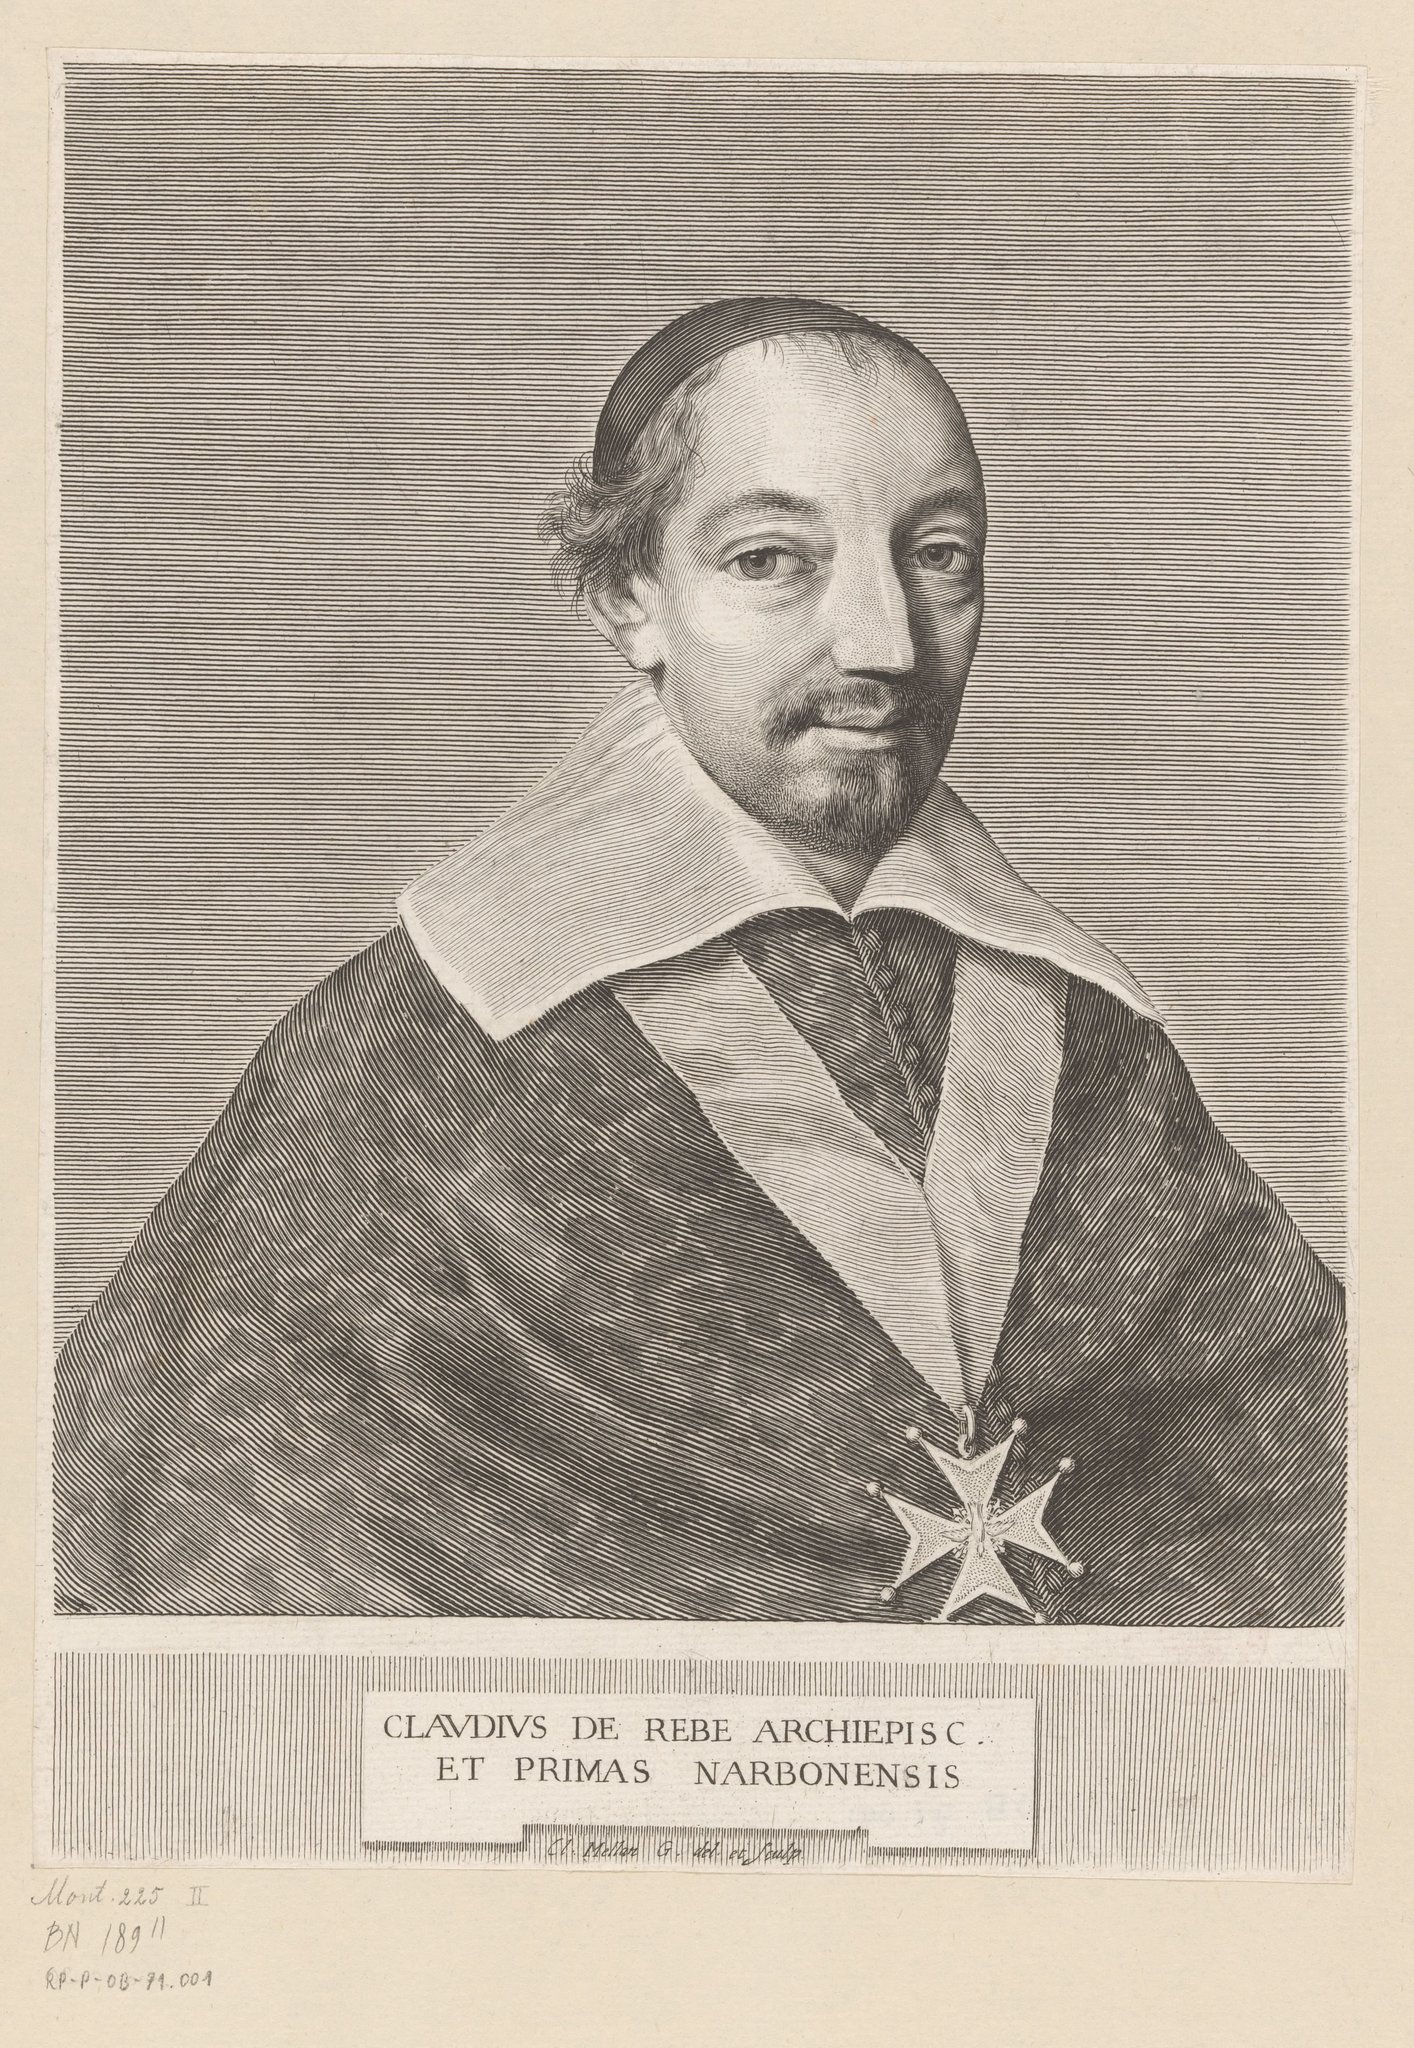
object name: print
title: Portret van Claude de Rebé, aartsbisschop van Narbonne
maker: claude mellan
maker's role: draughtsman, print maker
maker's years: 1598-1688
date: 1628-1688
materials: paper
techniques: engraving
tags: archbishop, bishop, etc. (roman catholic), historical persons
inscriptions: collector's mark: Lugt 240